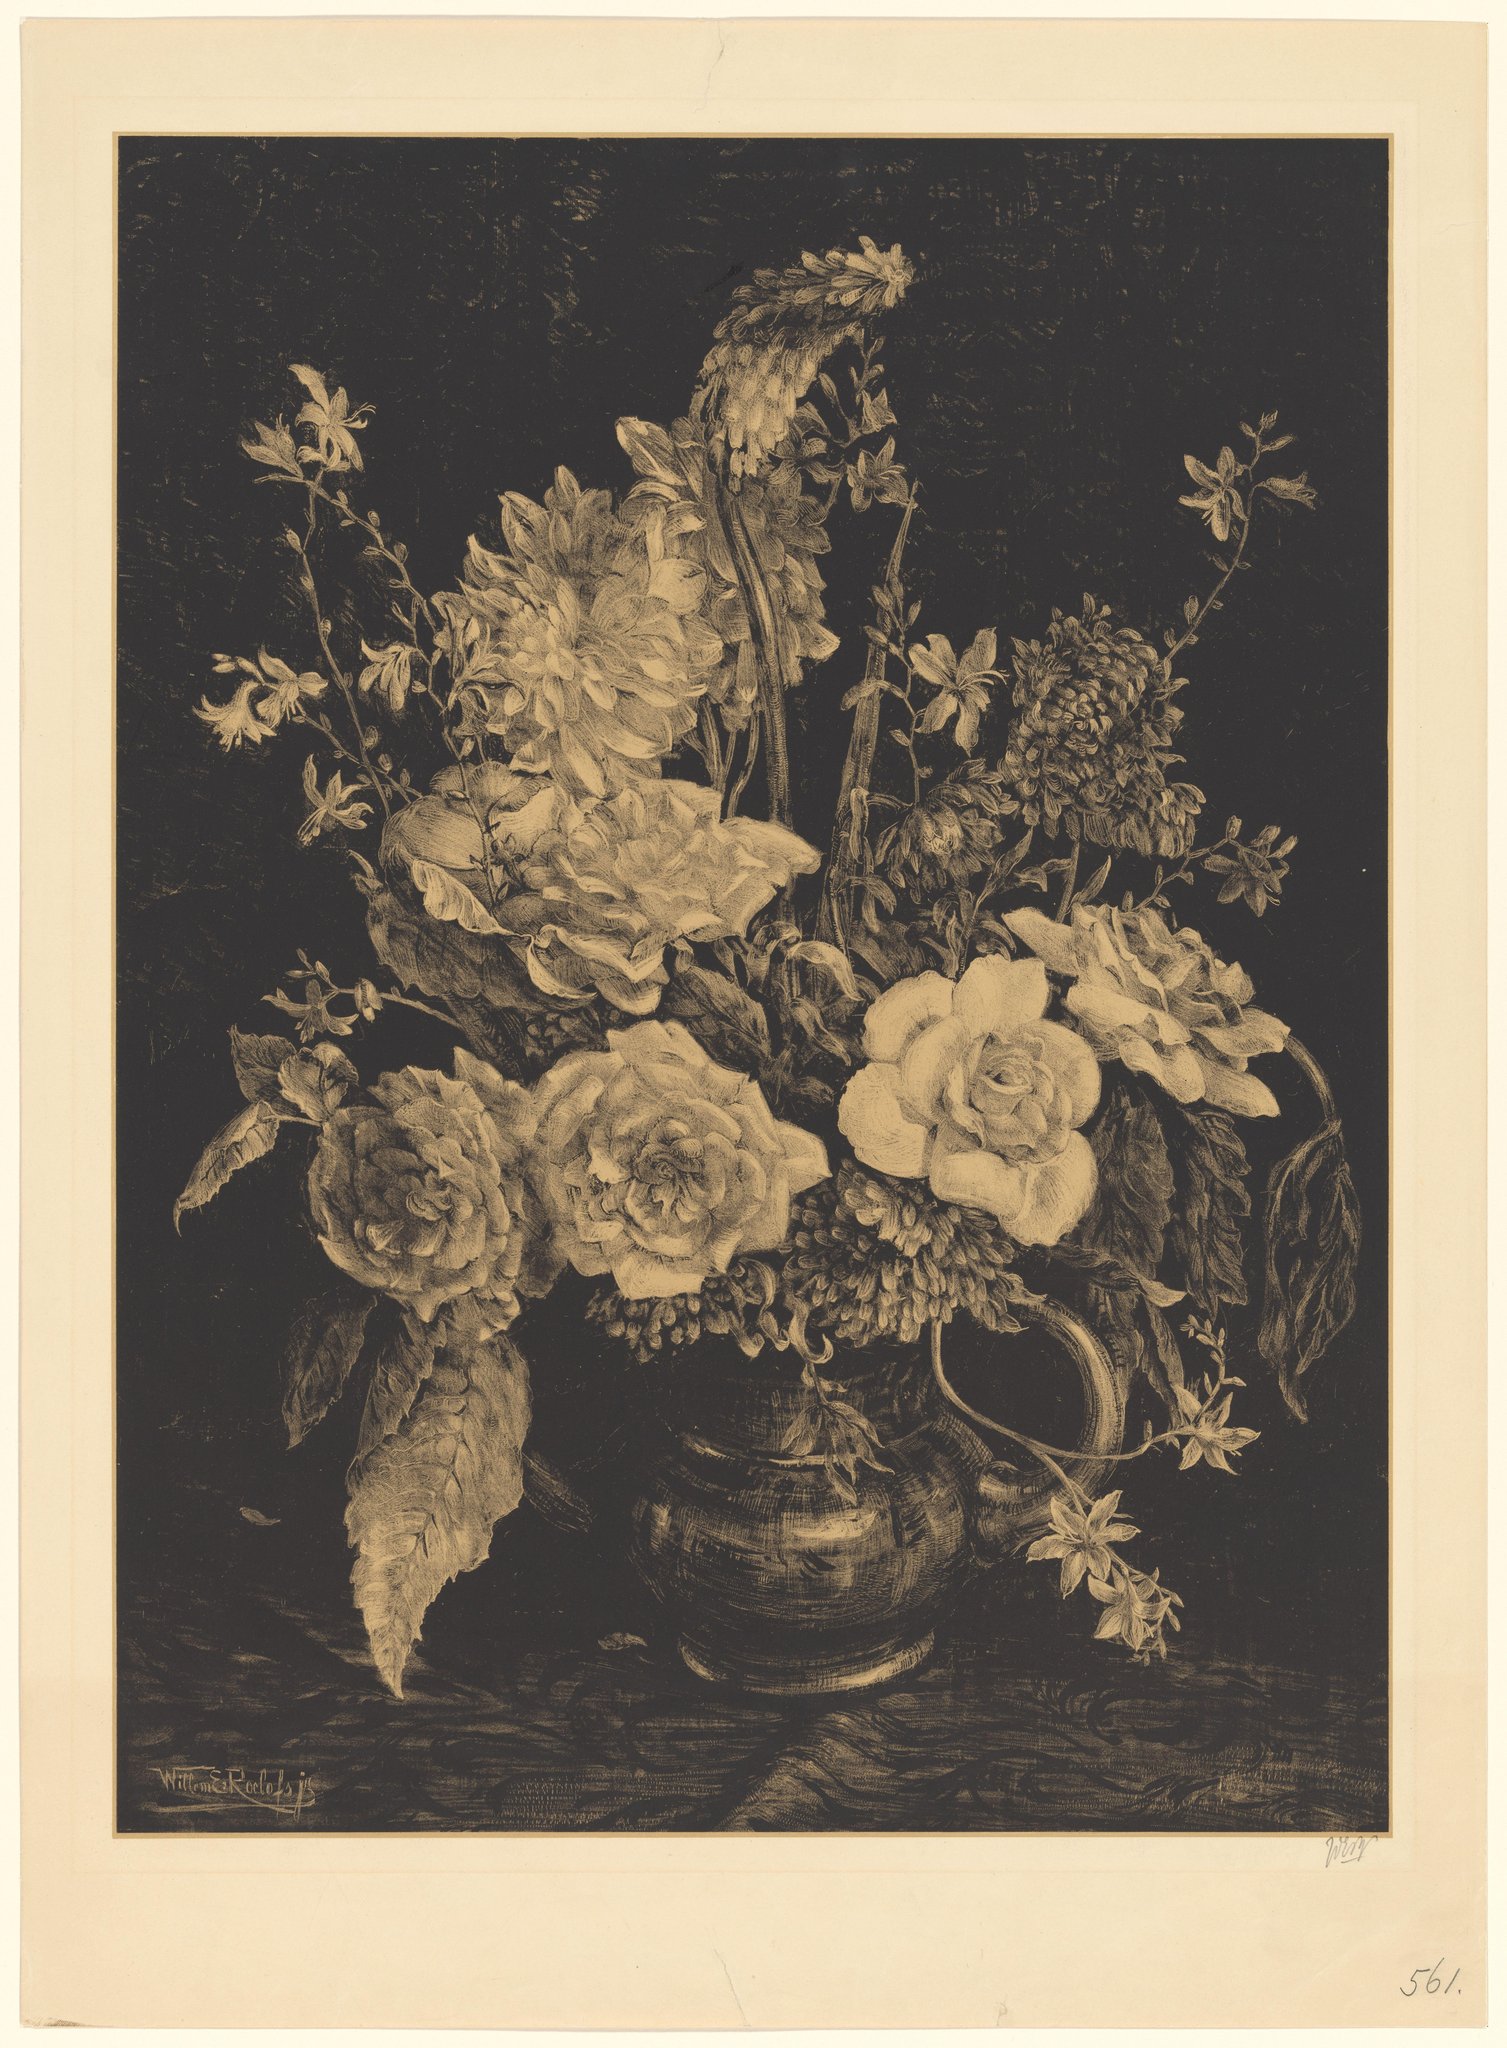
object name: print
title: Bloemen in een vaas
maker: willem roelofs (ii)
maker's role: draughtsman, painter, print maker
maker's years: 1874-1940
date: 1884-1940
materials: paper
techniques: lithograph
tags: flowers, flowers in a vase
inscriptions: collector's mark: Lugt 2228, collector's mark: Lugt 2760